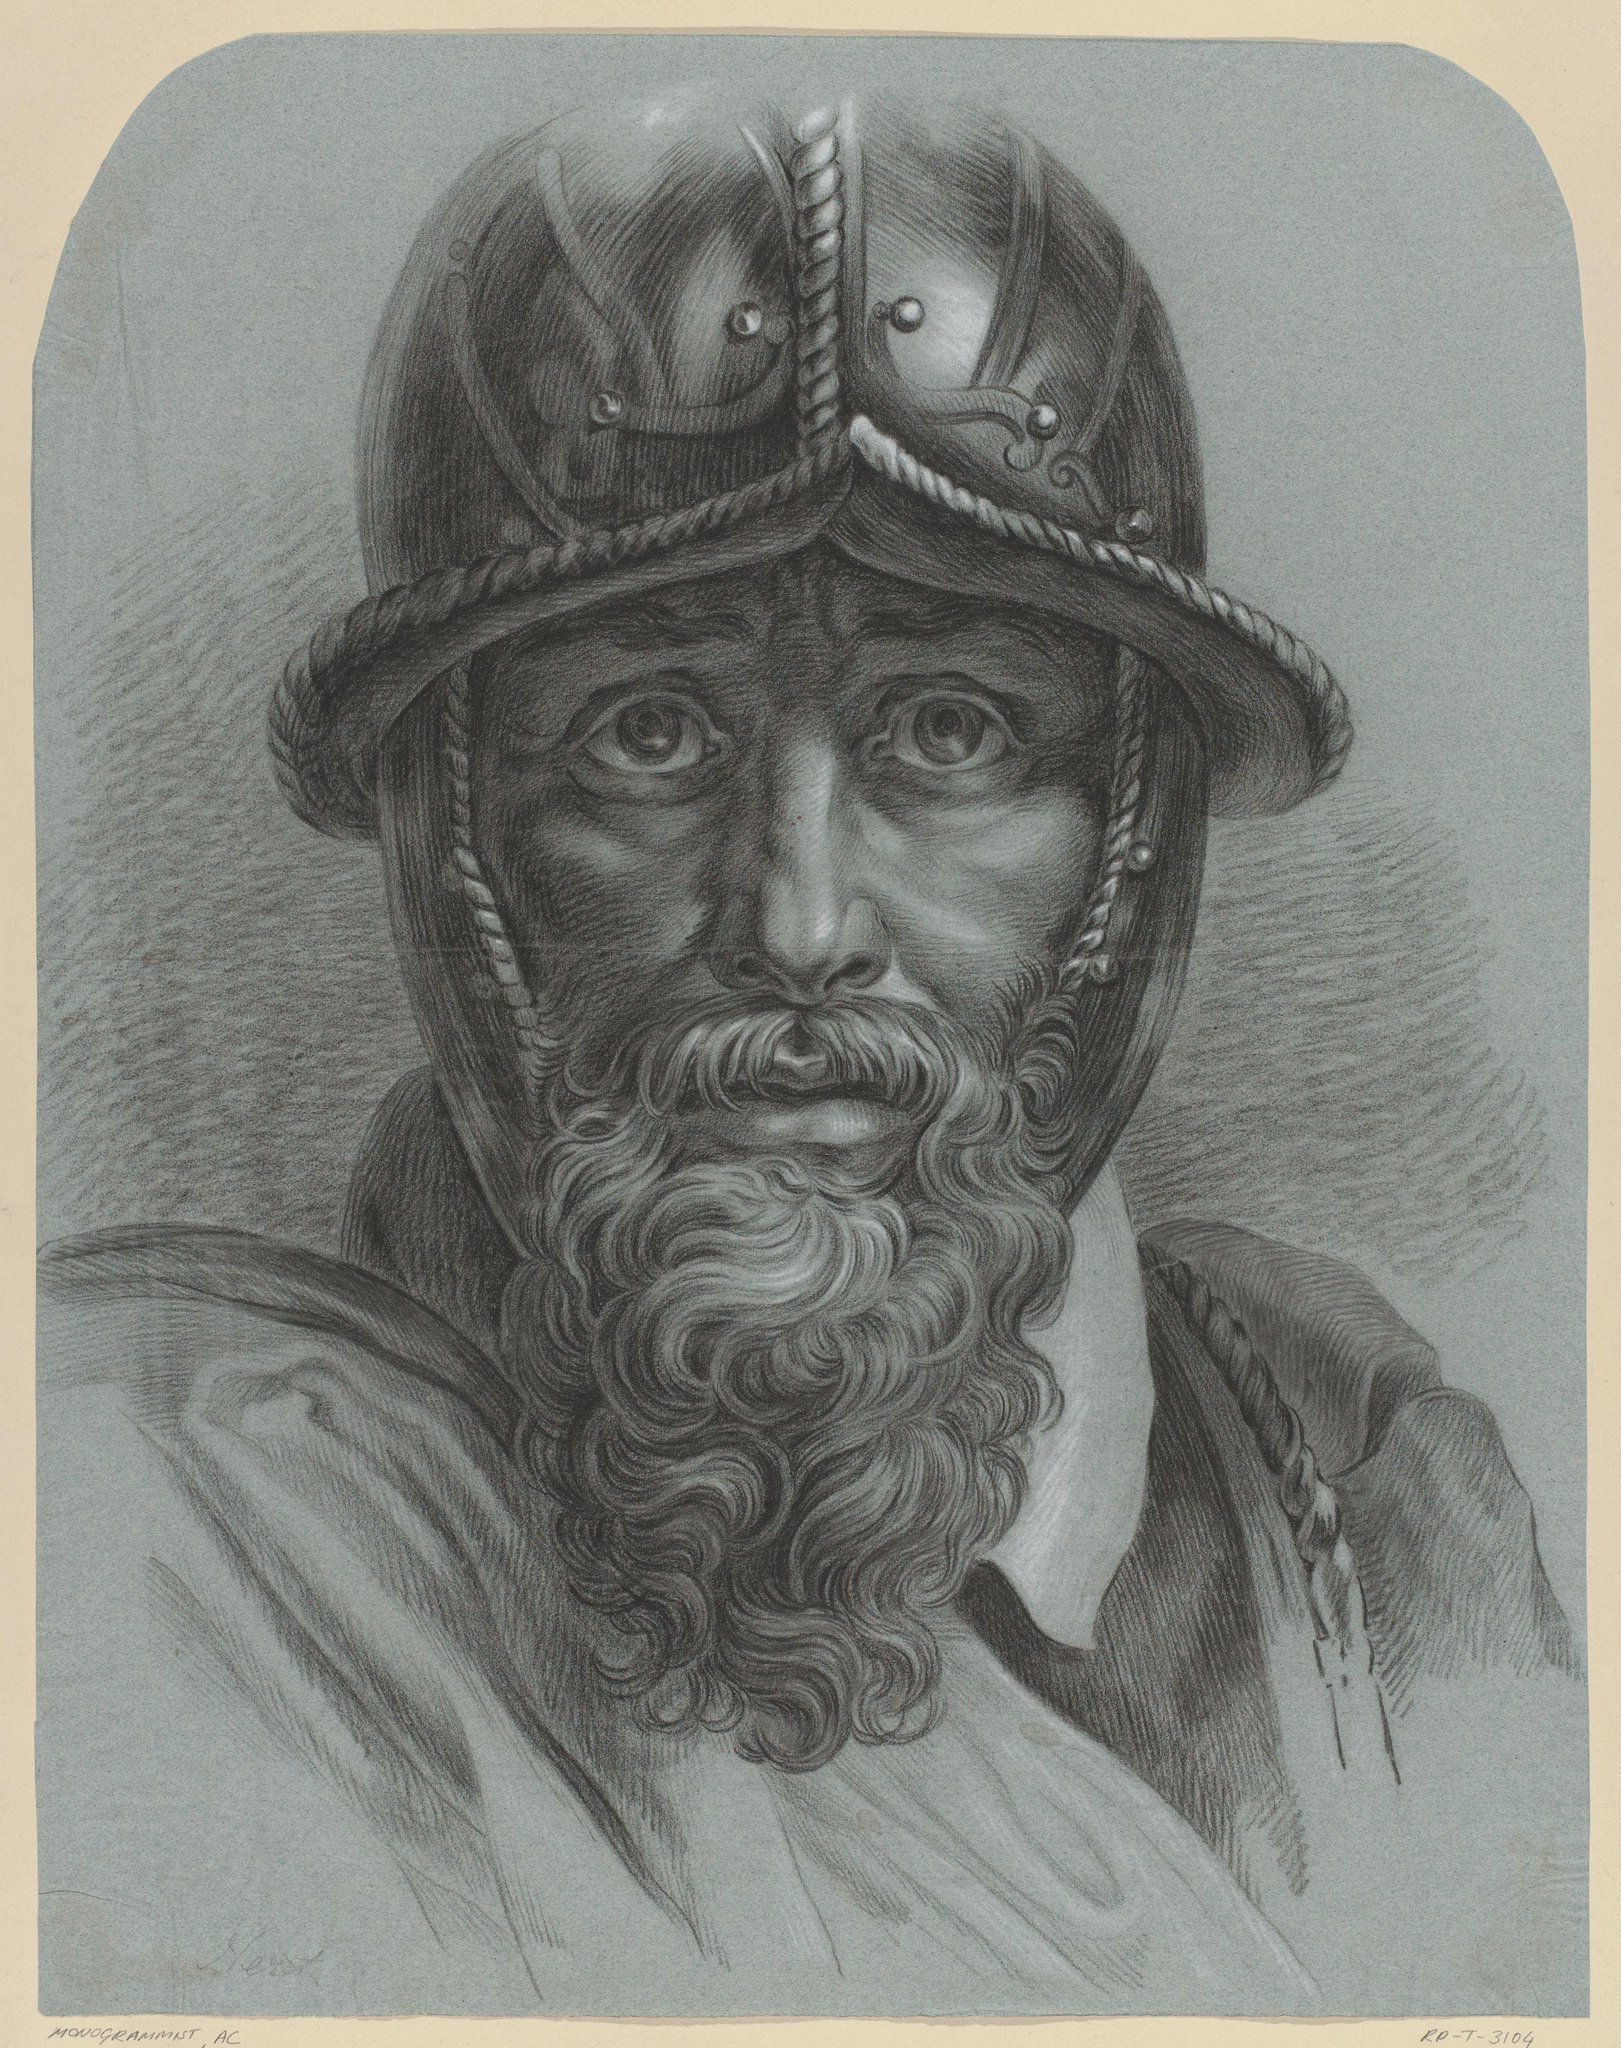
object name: drawing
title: Hoofd van een man met helm en baard, van voren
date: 1800-1899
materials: chalk, paper